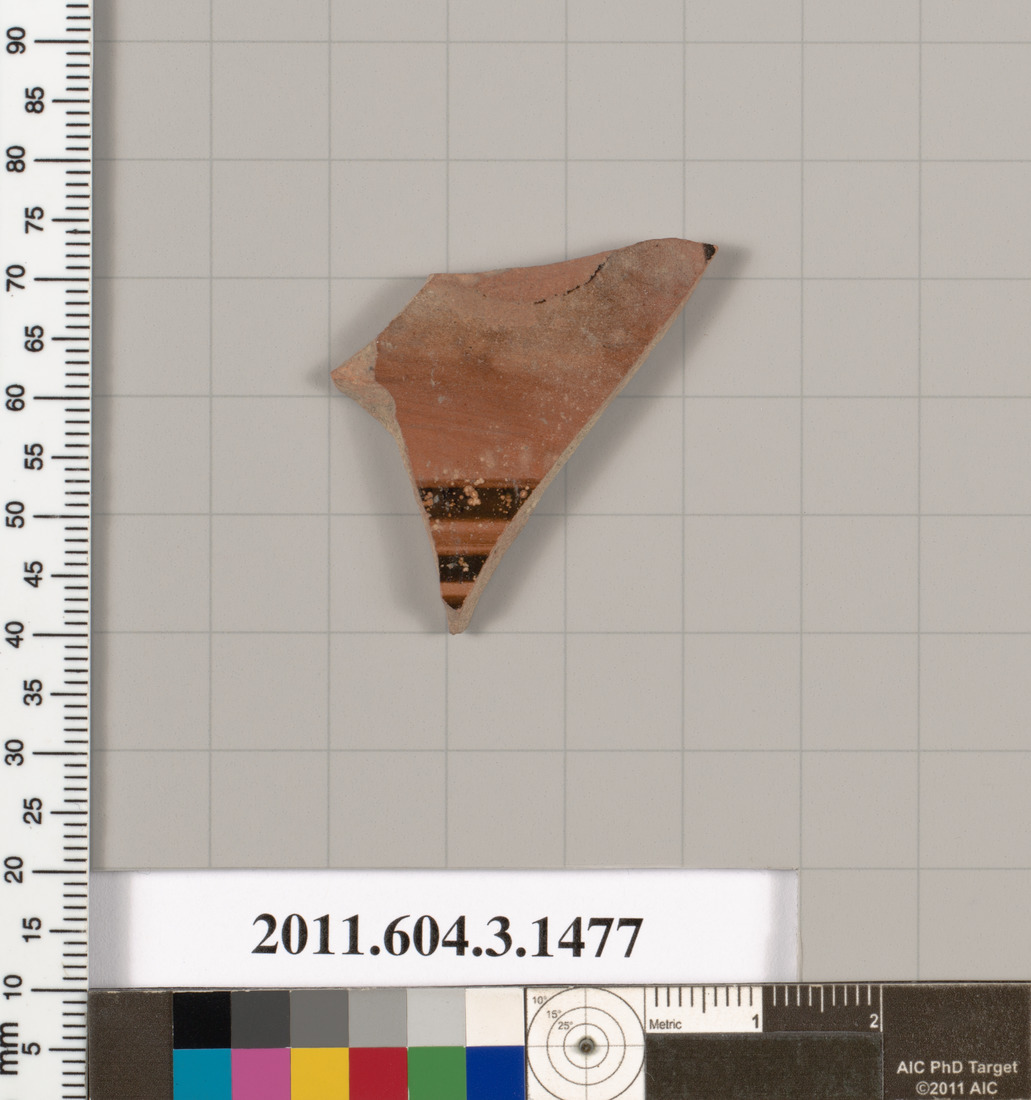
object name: skyphos fragment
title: Terracotta fragment of a skyphos (deep drinking cup)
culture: greek, attic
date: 600-401 BCE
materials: terracotta